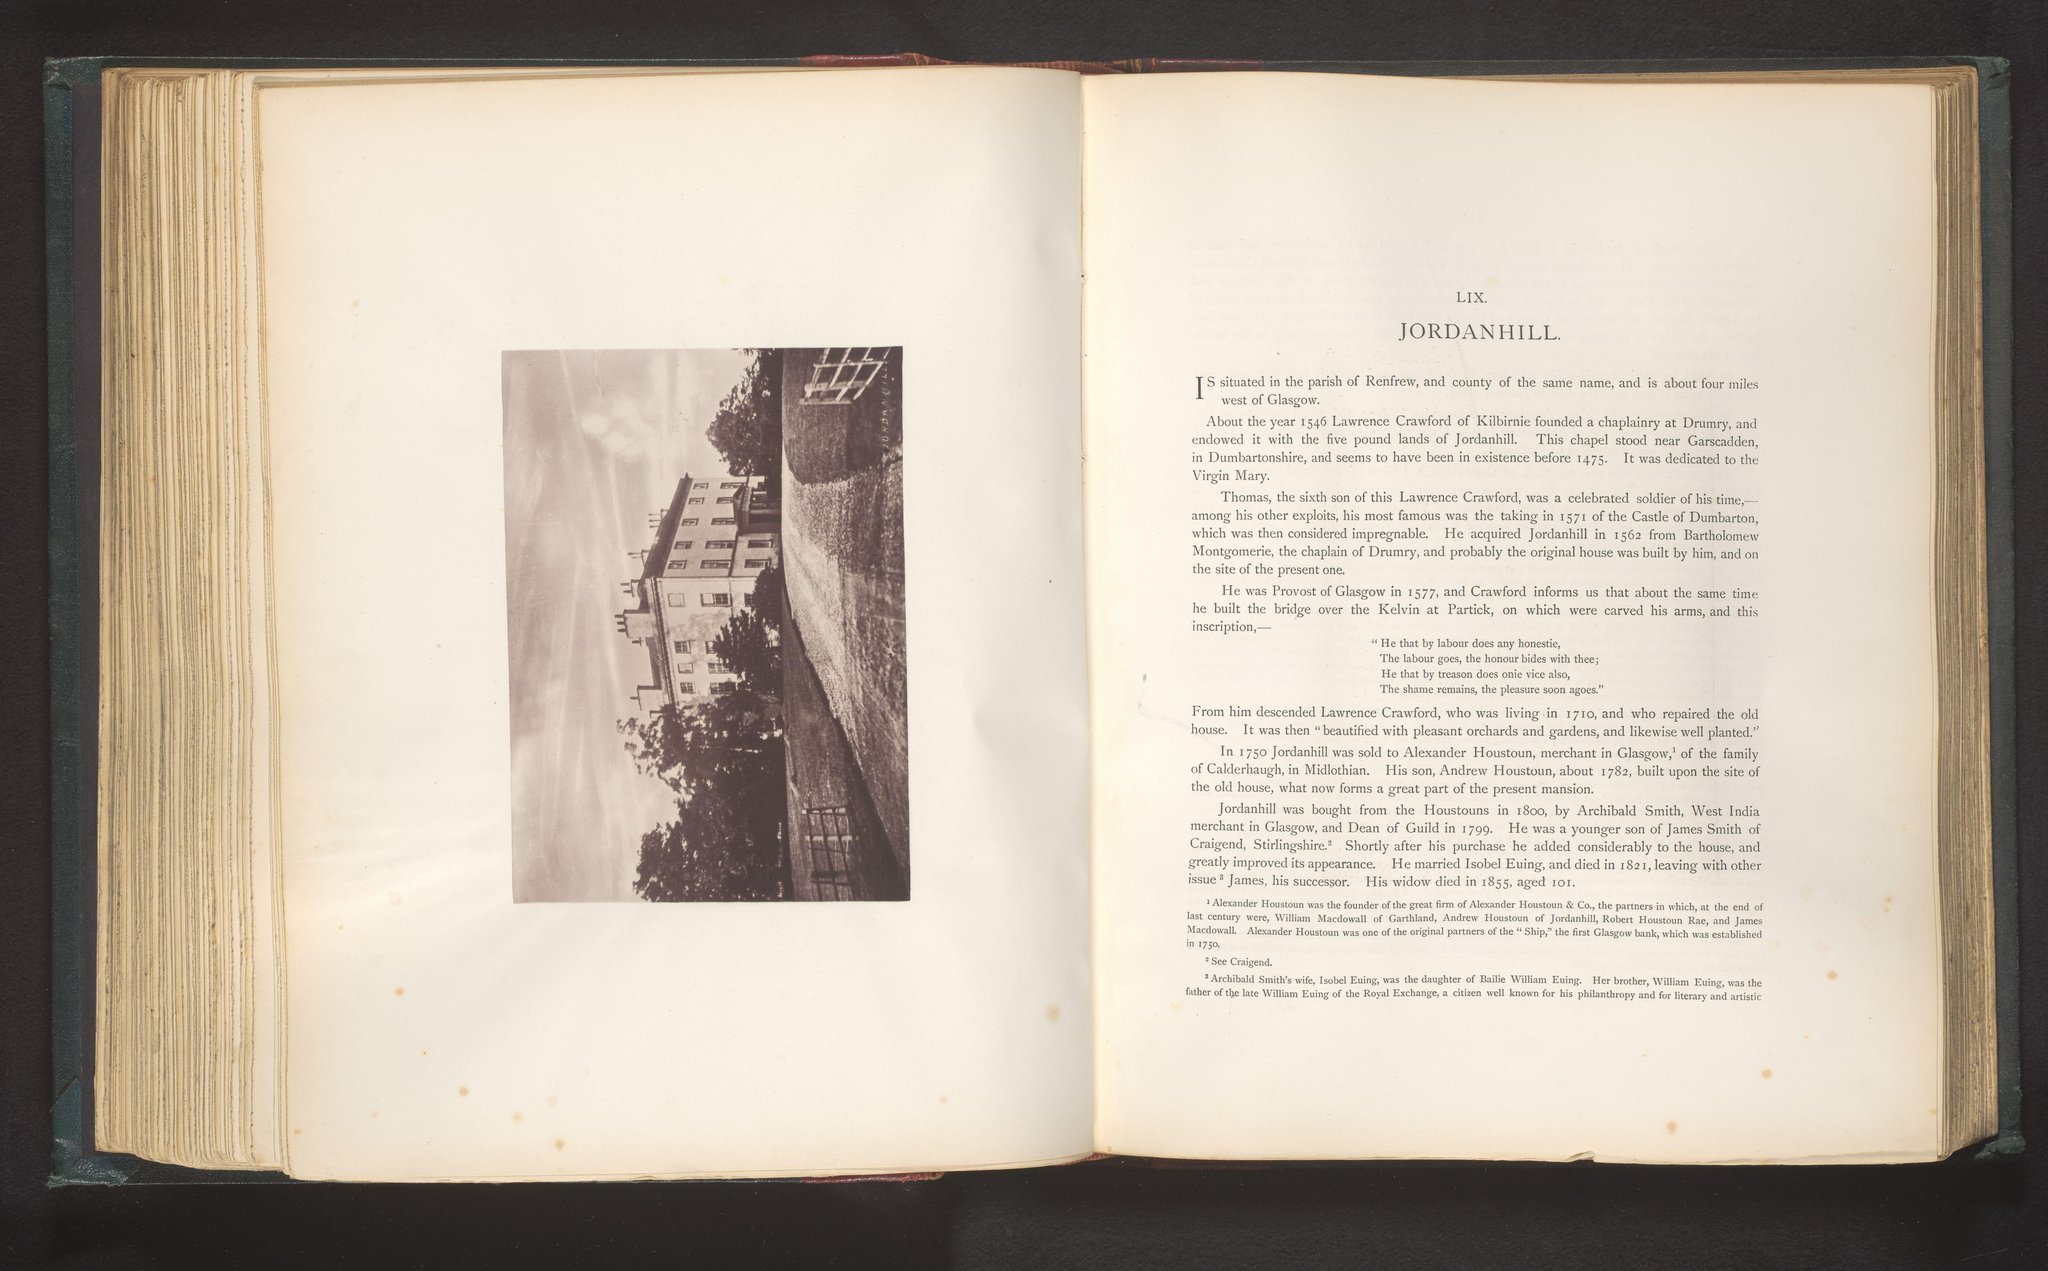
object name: page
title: Jordanhill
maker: thomas annan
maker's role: fotograaf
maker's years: 1829-1887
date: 1868-1878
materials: paper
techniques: carbon print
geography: glasgow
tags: rural housing, e.g. country-house, villa, cottage, façade (of house or building)